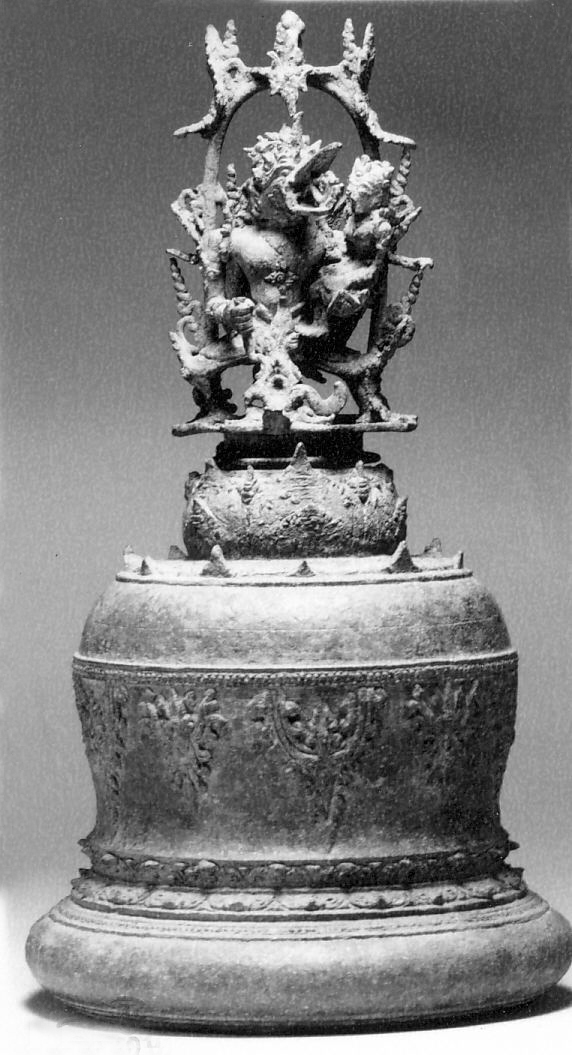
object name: sculpture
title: Monster-Headed Male Deity with Consort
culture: indonesian, javanese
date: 901-1100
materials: bronze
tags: monsters,deities